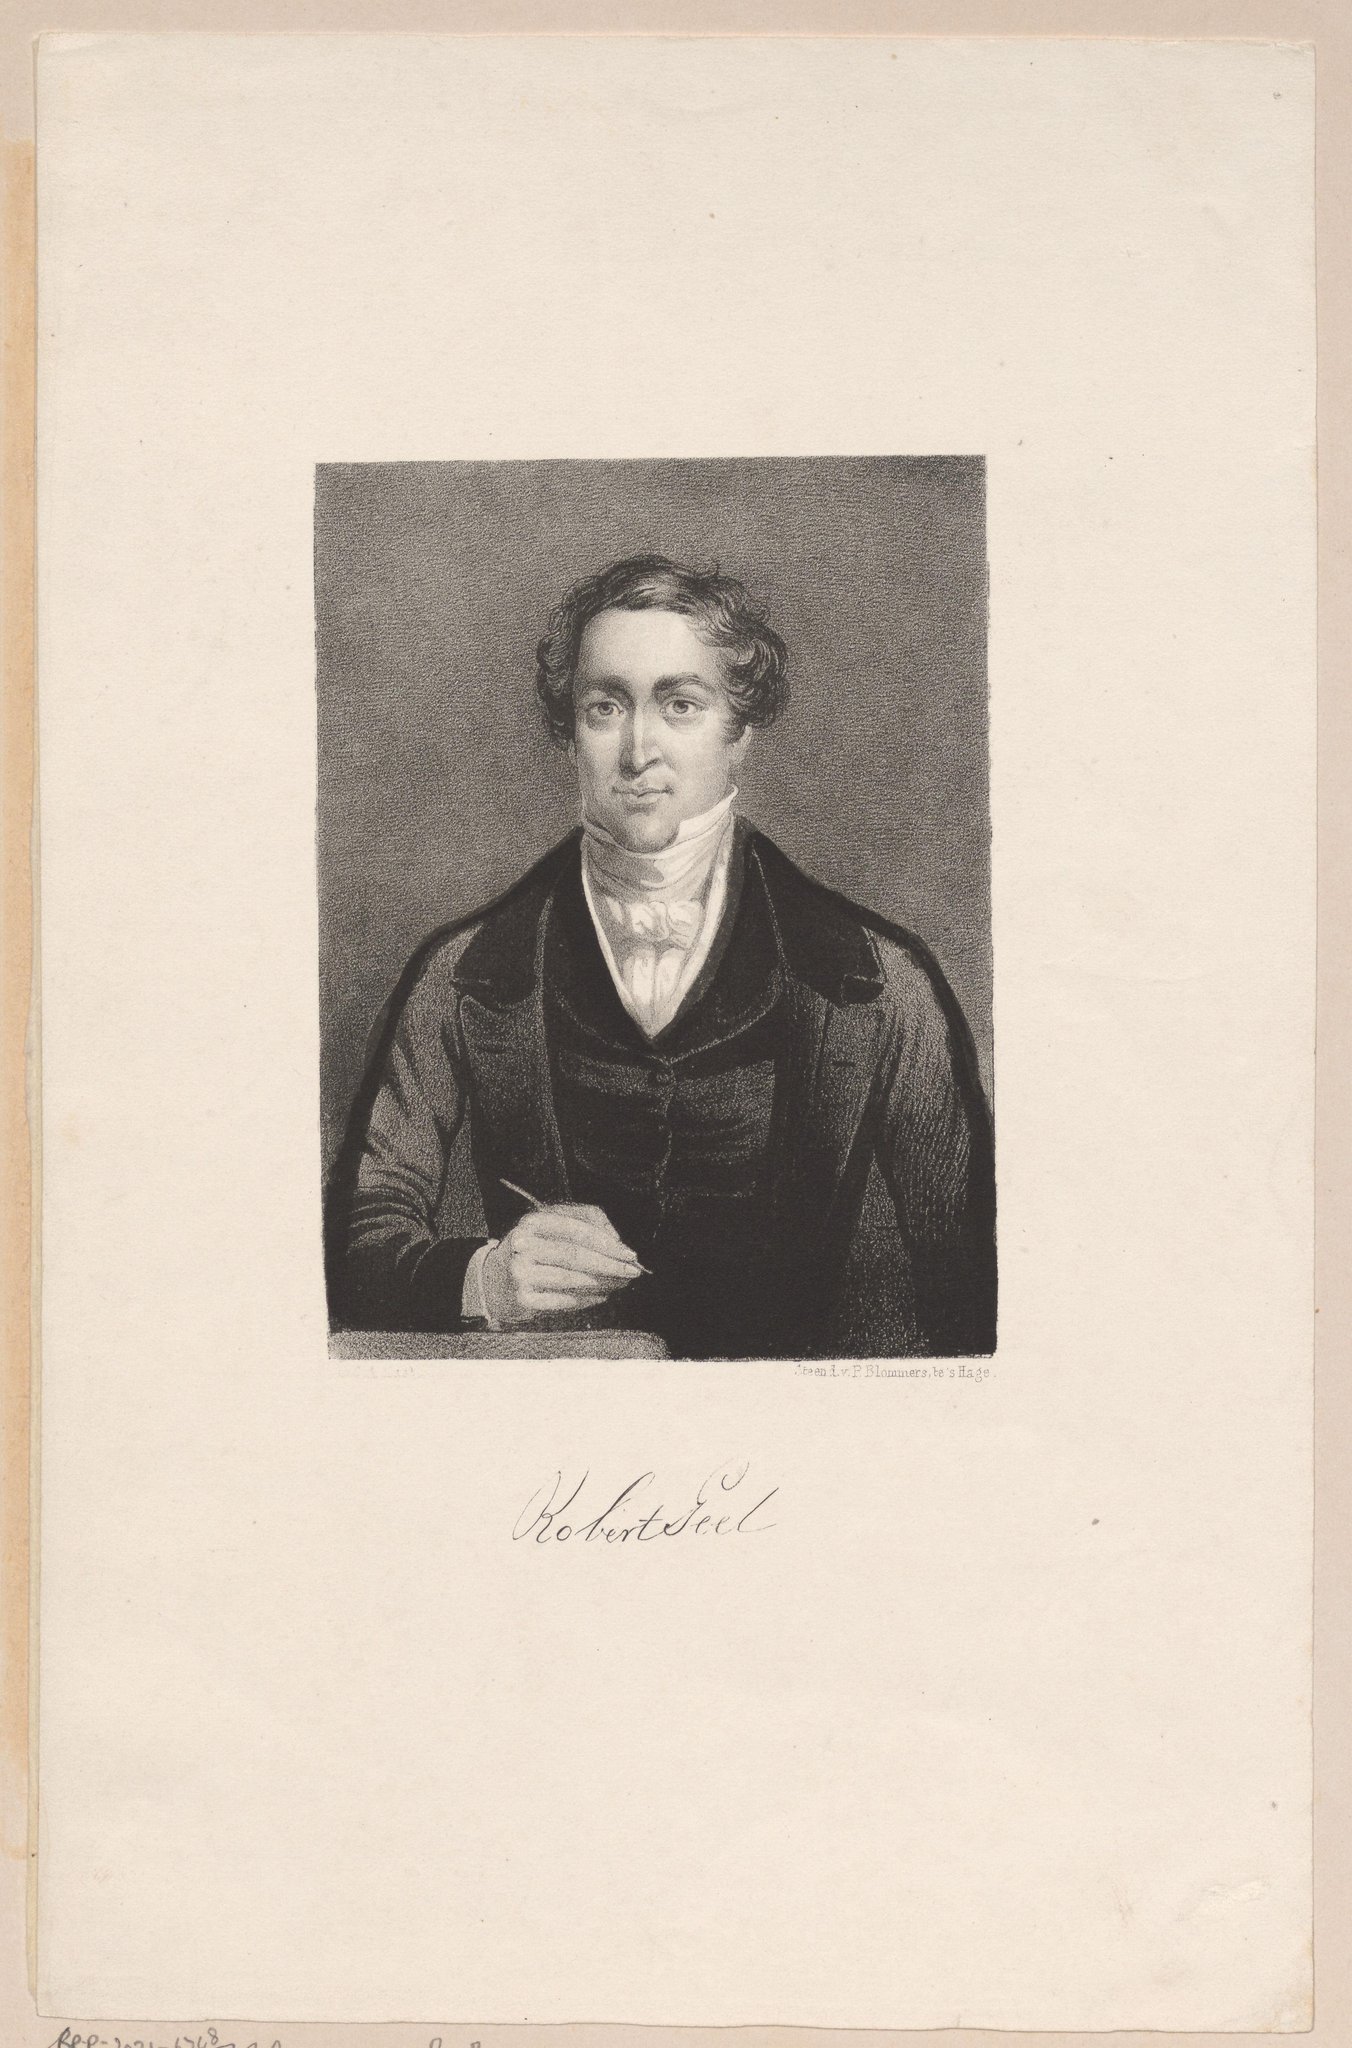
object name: print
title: Portret van Robert Peel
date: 1842-1876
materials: paper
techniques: lithograph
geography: the hague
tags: adult man, historical persons, writing accessories